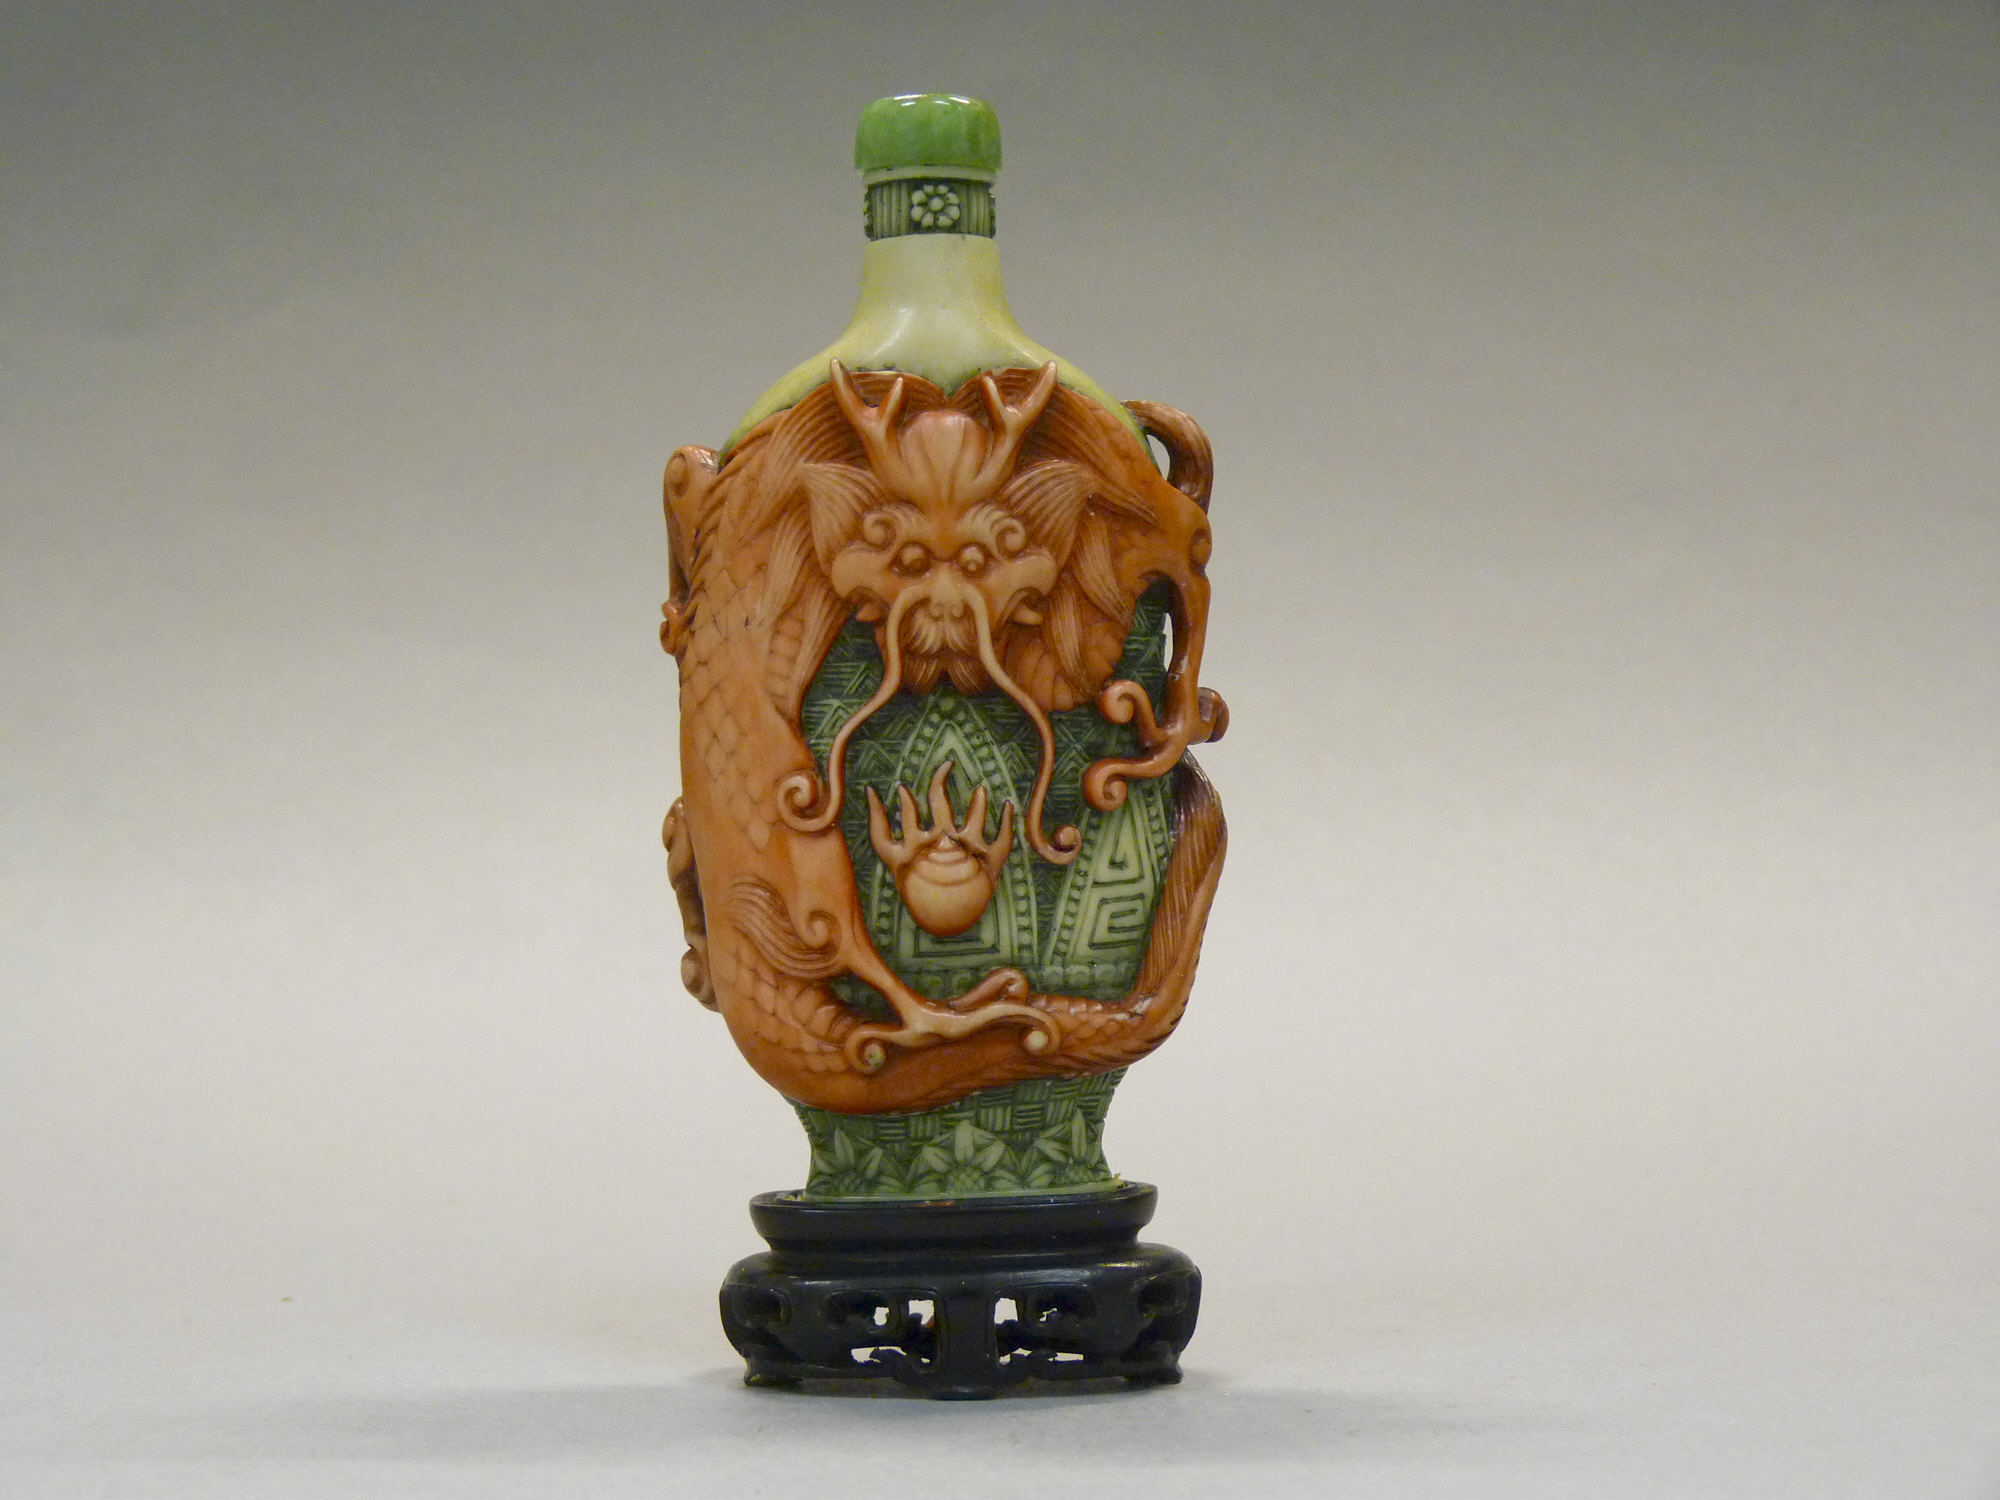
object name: snuff bottle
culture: chinese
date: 1801-1900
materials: ivory, jade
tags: dragons